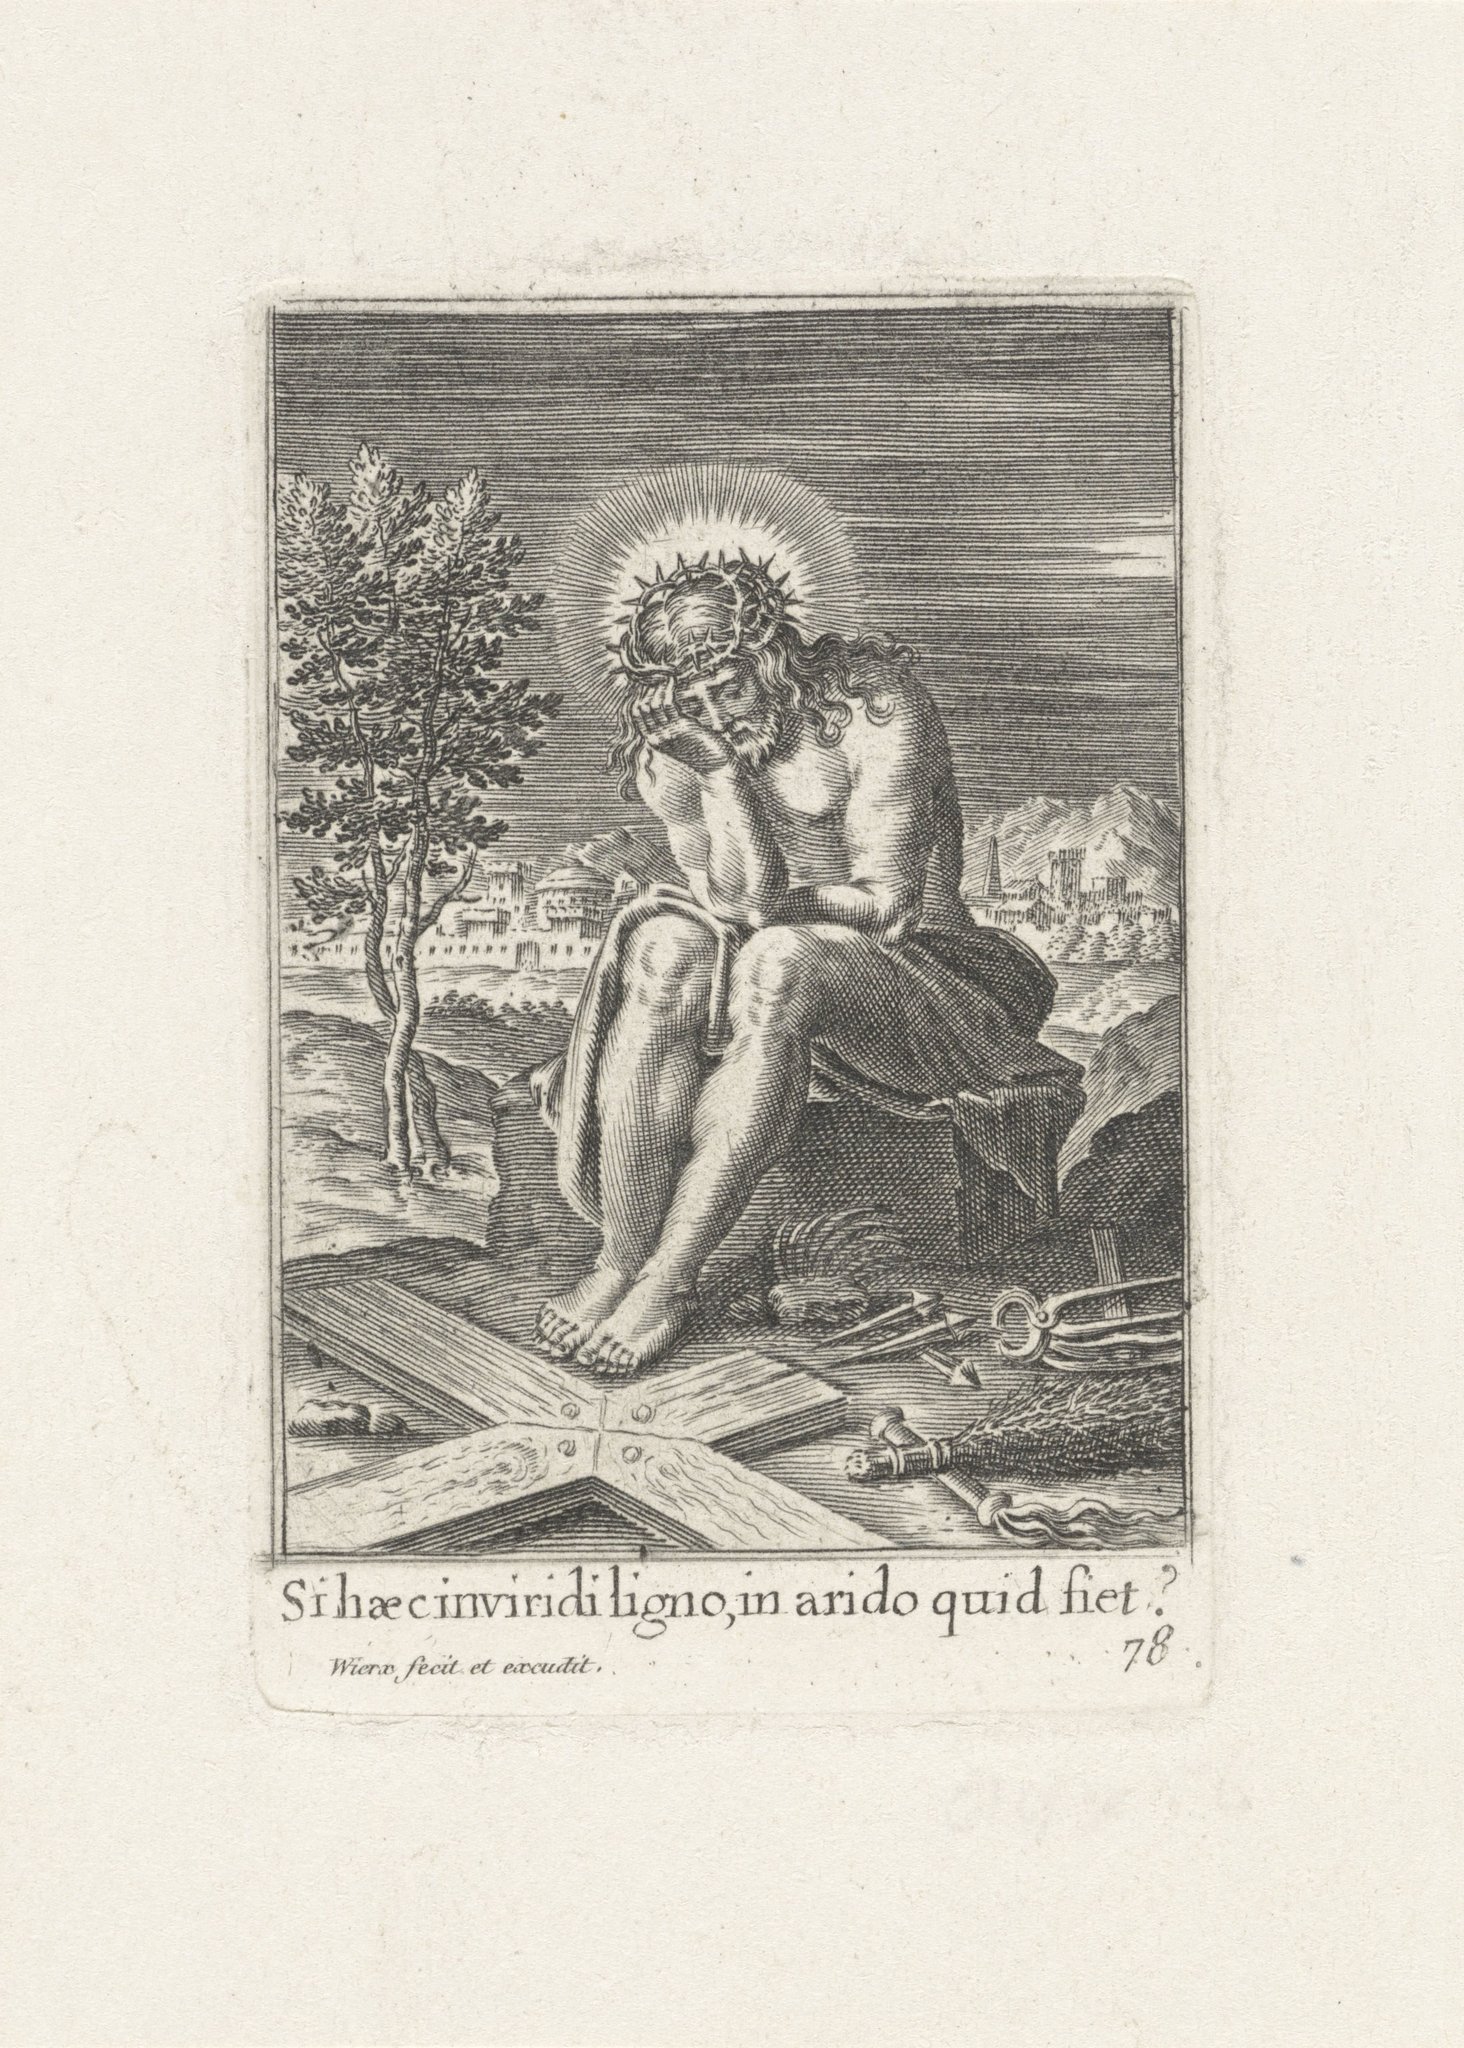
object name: print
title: Christus op de koude steen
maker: wierix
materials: paper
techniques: engraving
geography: antwerp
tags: christ in agony waiting to be crucified; he is sitting on or near the cross or on a stone, 'christus im elend', 'christus in der rast'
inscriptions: collector's mark: Lugt 2228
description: De peinzende Christus zit ineengedoken op een steen naast het kruis, in afwachting van zijn kruisiging. Aan zijn voeten liggen de passiewerktuigen. Op de achtergrond een gezicht op Jeruzalem. In de marge een onderschrift in het Latijn. Rechtsonder genummerd: 78.